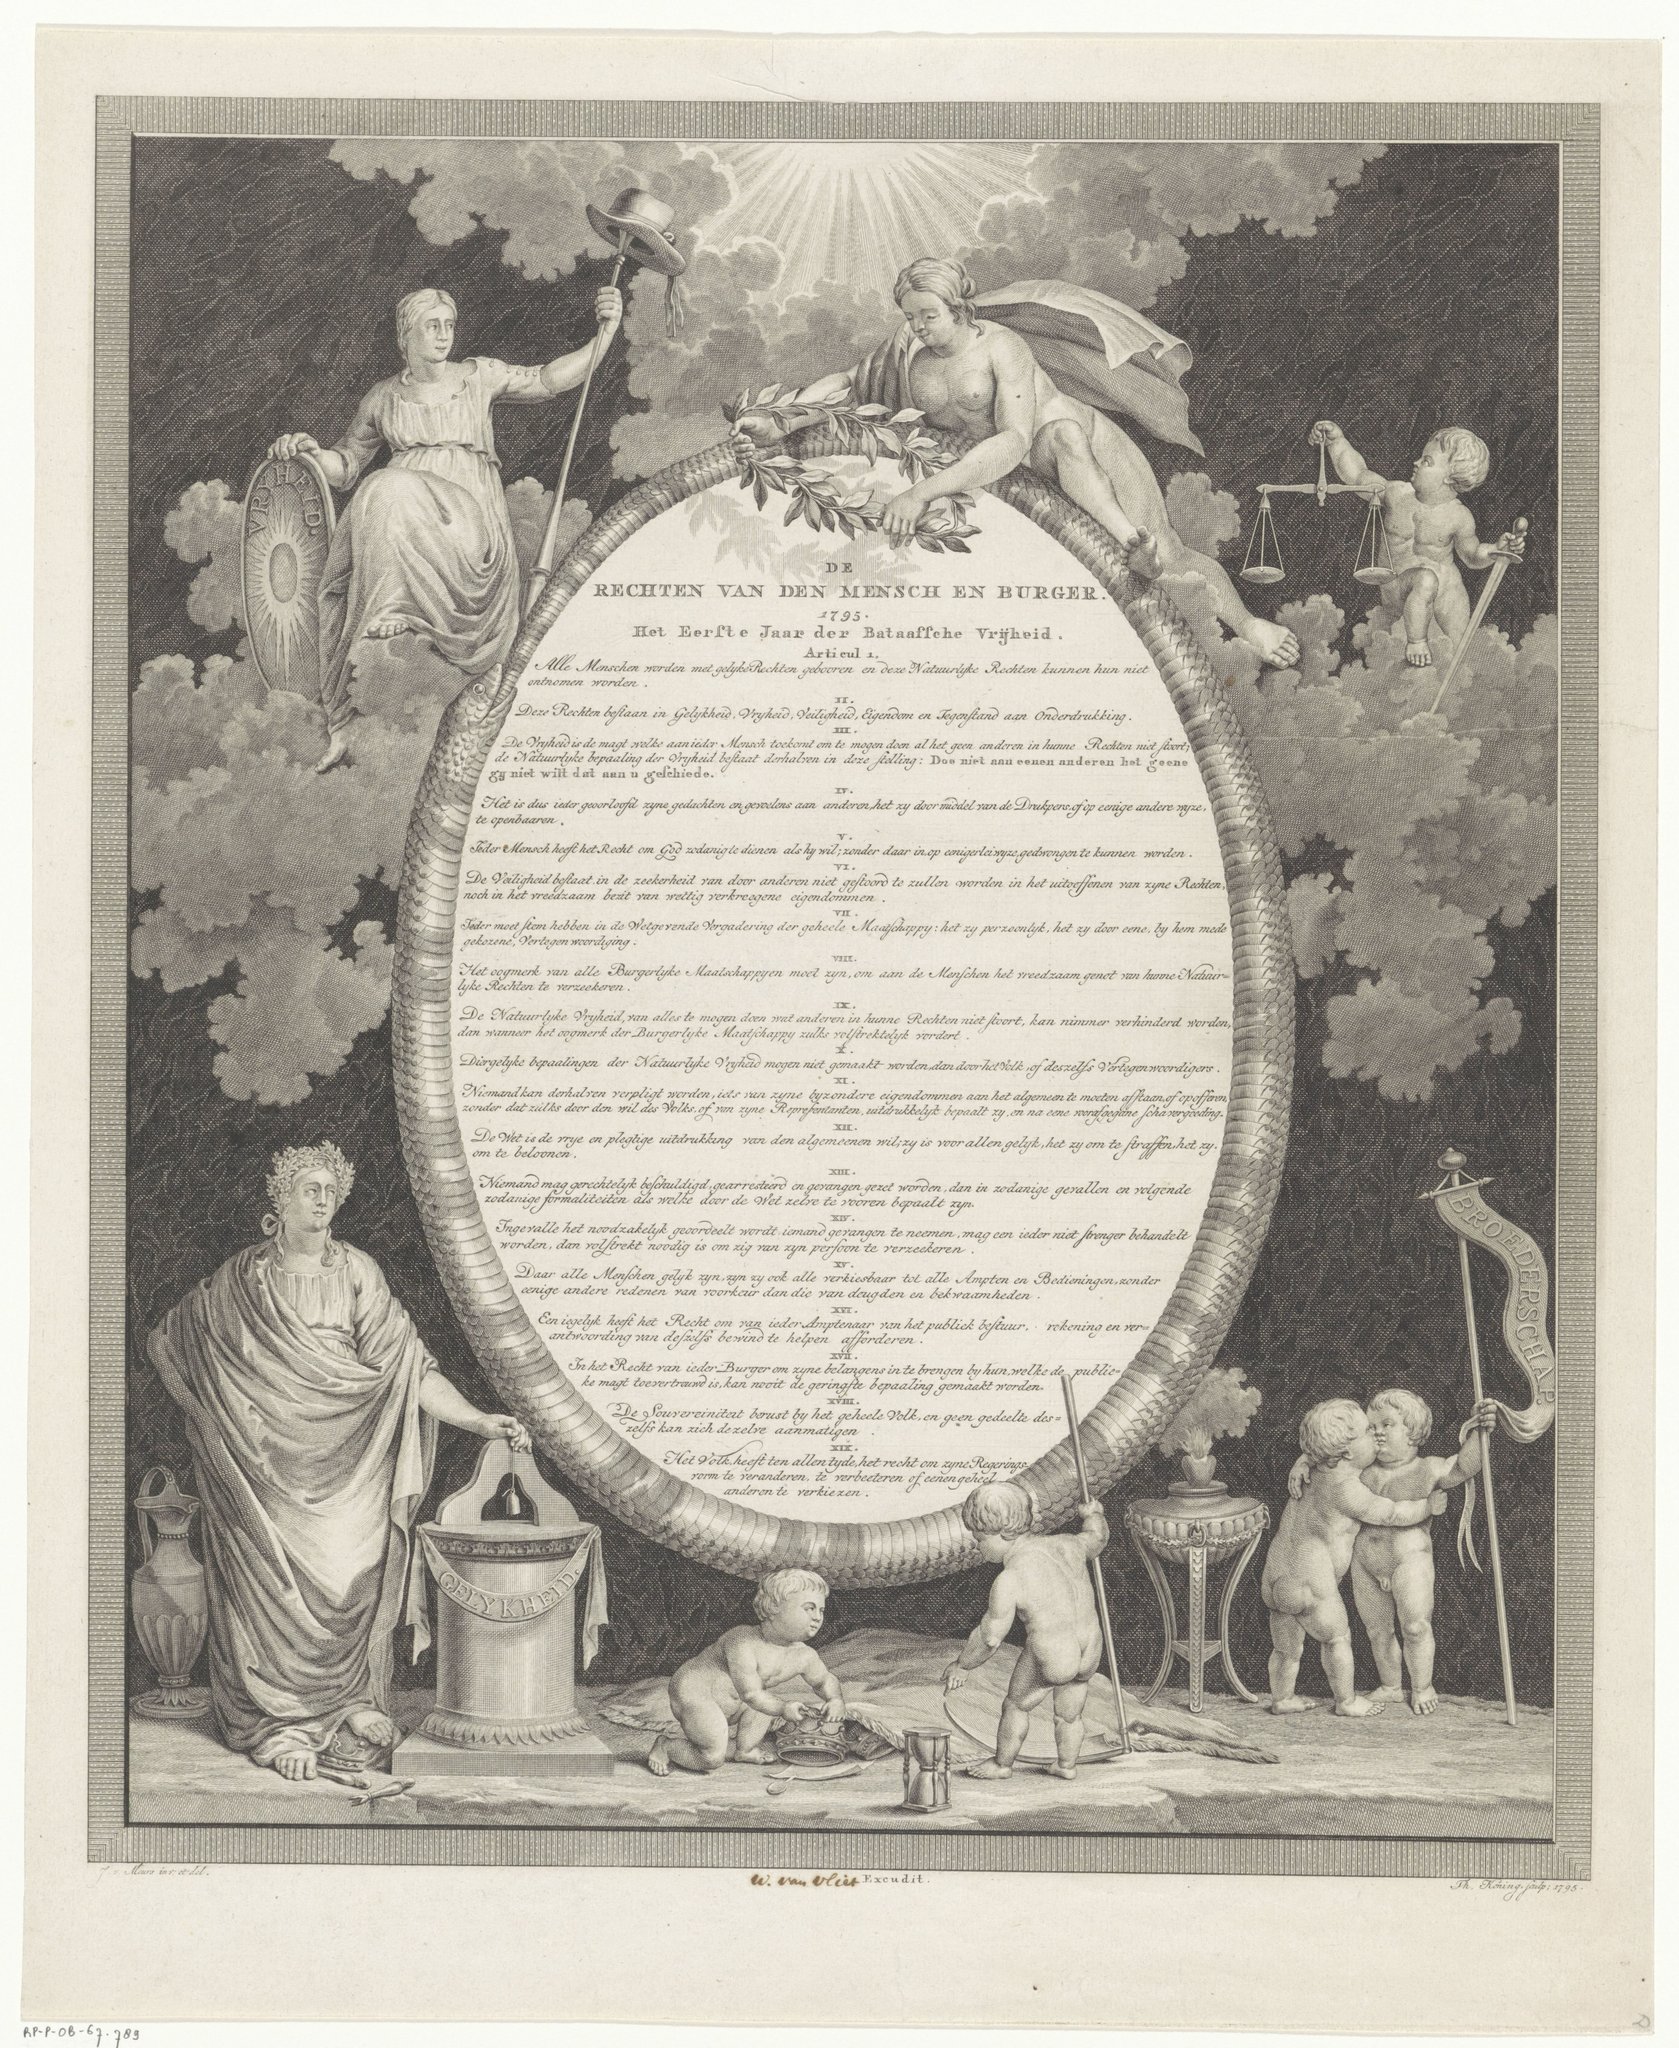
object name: print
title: De Rechten van den Mensch en Burger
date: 1795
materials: paper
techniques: engraving, etching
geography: amsterdam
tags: civil law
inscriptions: collector's mark: Lugt 2228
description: Op een ovaal staan de negentien artikelen van de nieuw uitgegeven burgerrechten in 1795. Het ovaal is omlijst door een slang die in zijn eigen staart bijt - het symbool voor eeuwigheid. De lijst is omringt door personificaties van Vrijheid, Gelijkheid, Broederschap, de Tijd en Rechtvaardigheid.